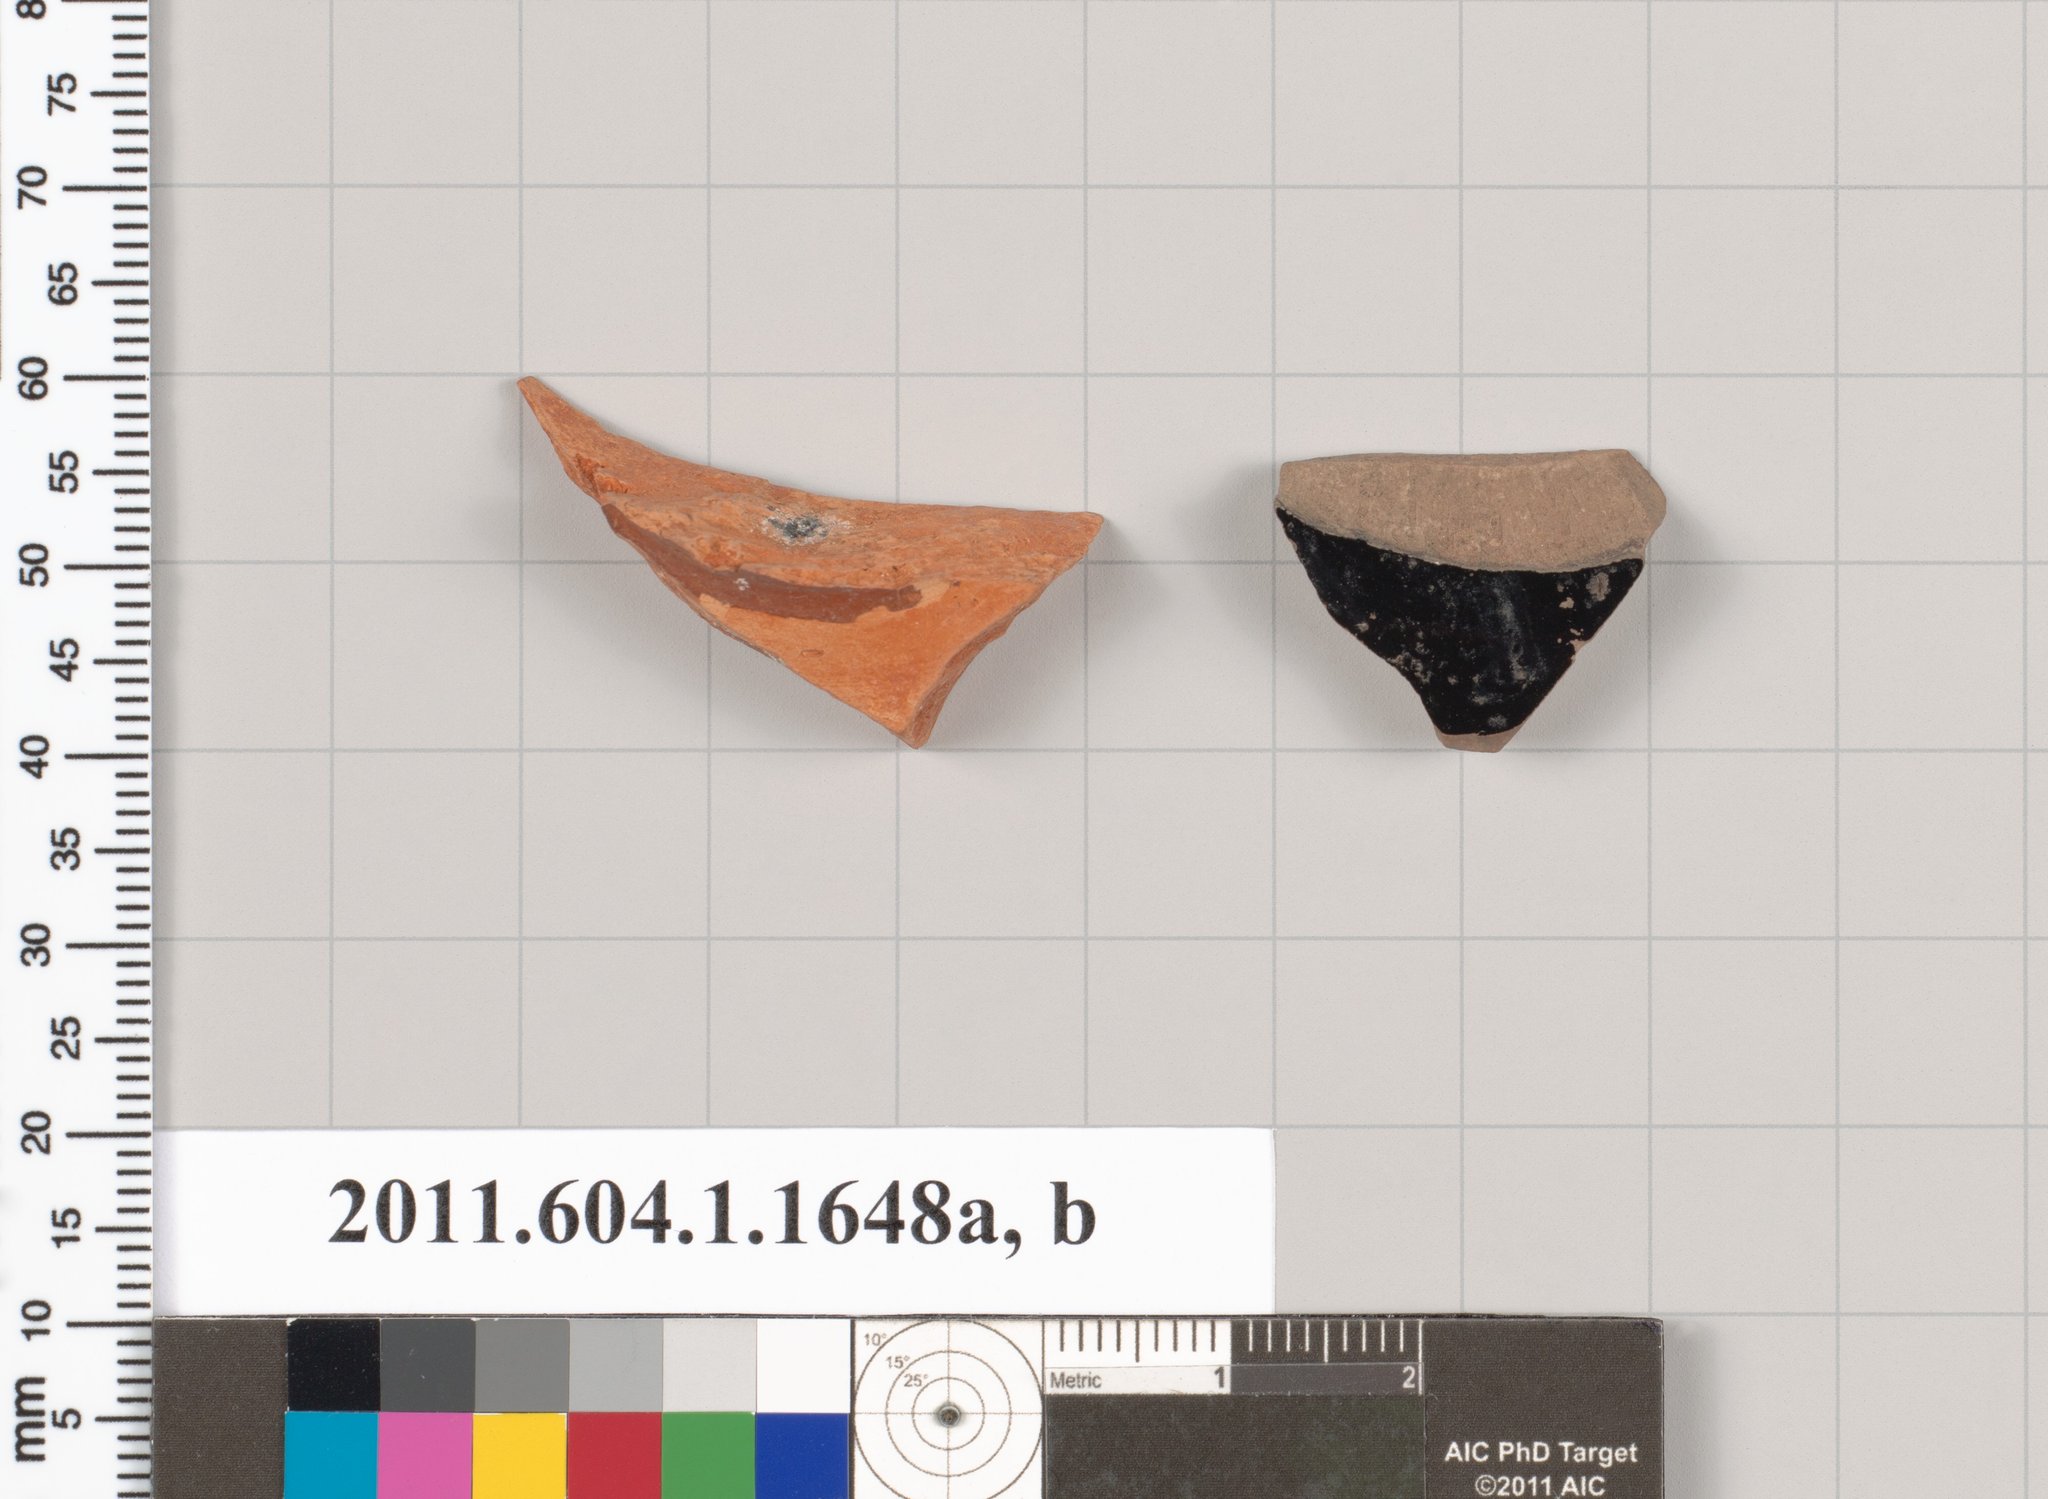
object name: kylix fragment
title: Terracotta fragments of kylikes (drinking cups)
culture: greek, attic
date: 500-401 BCE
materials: terracotta